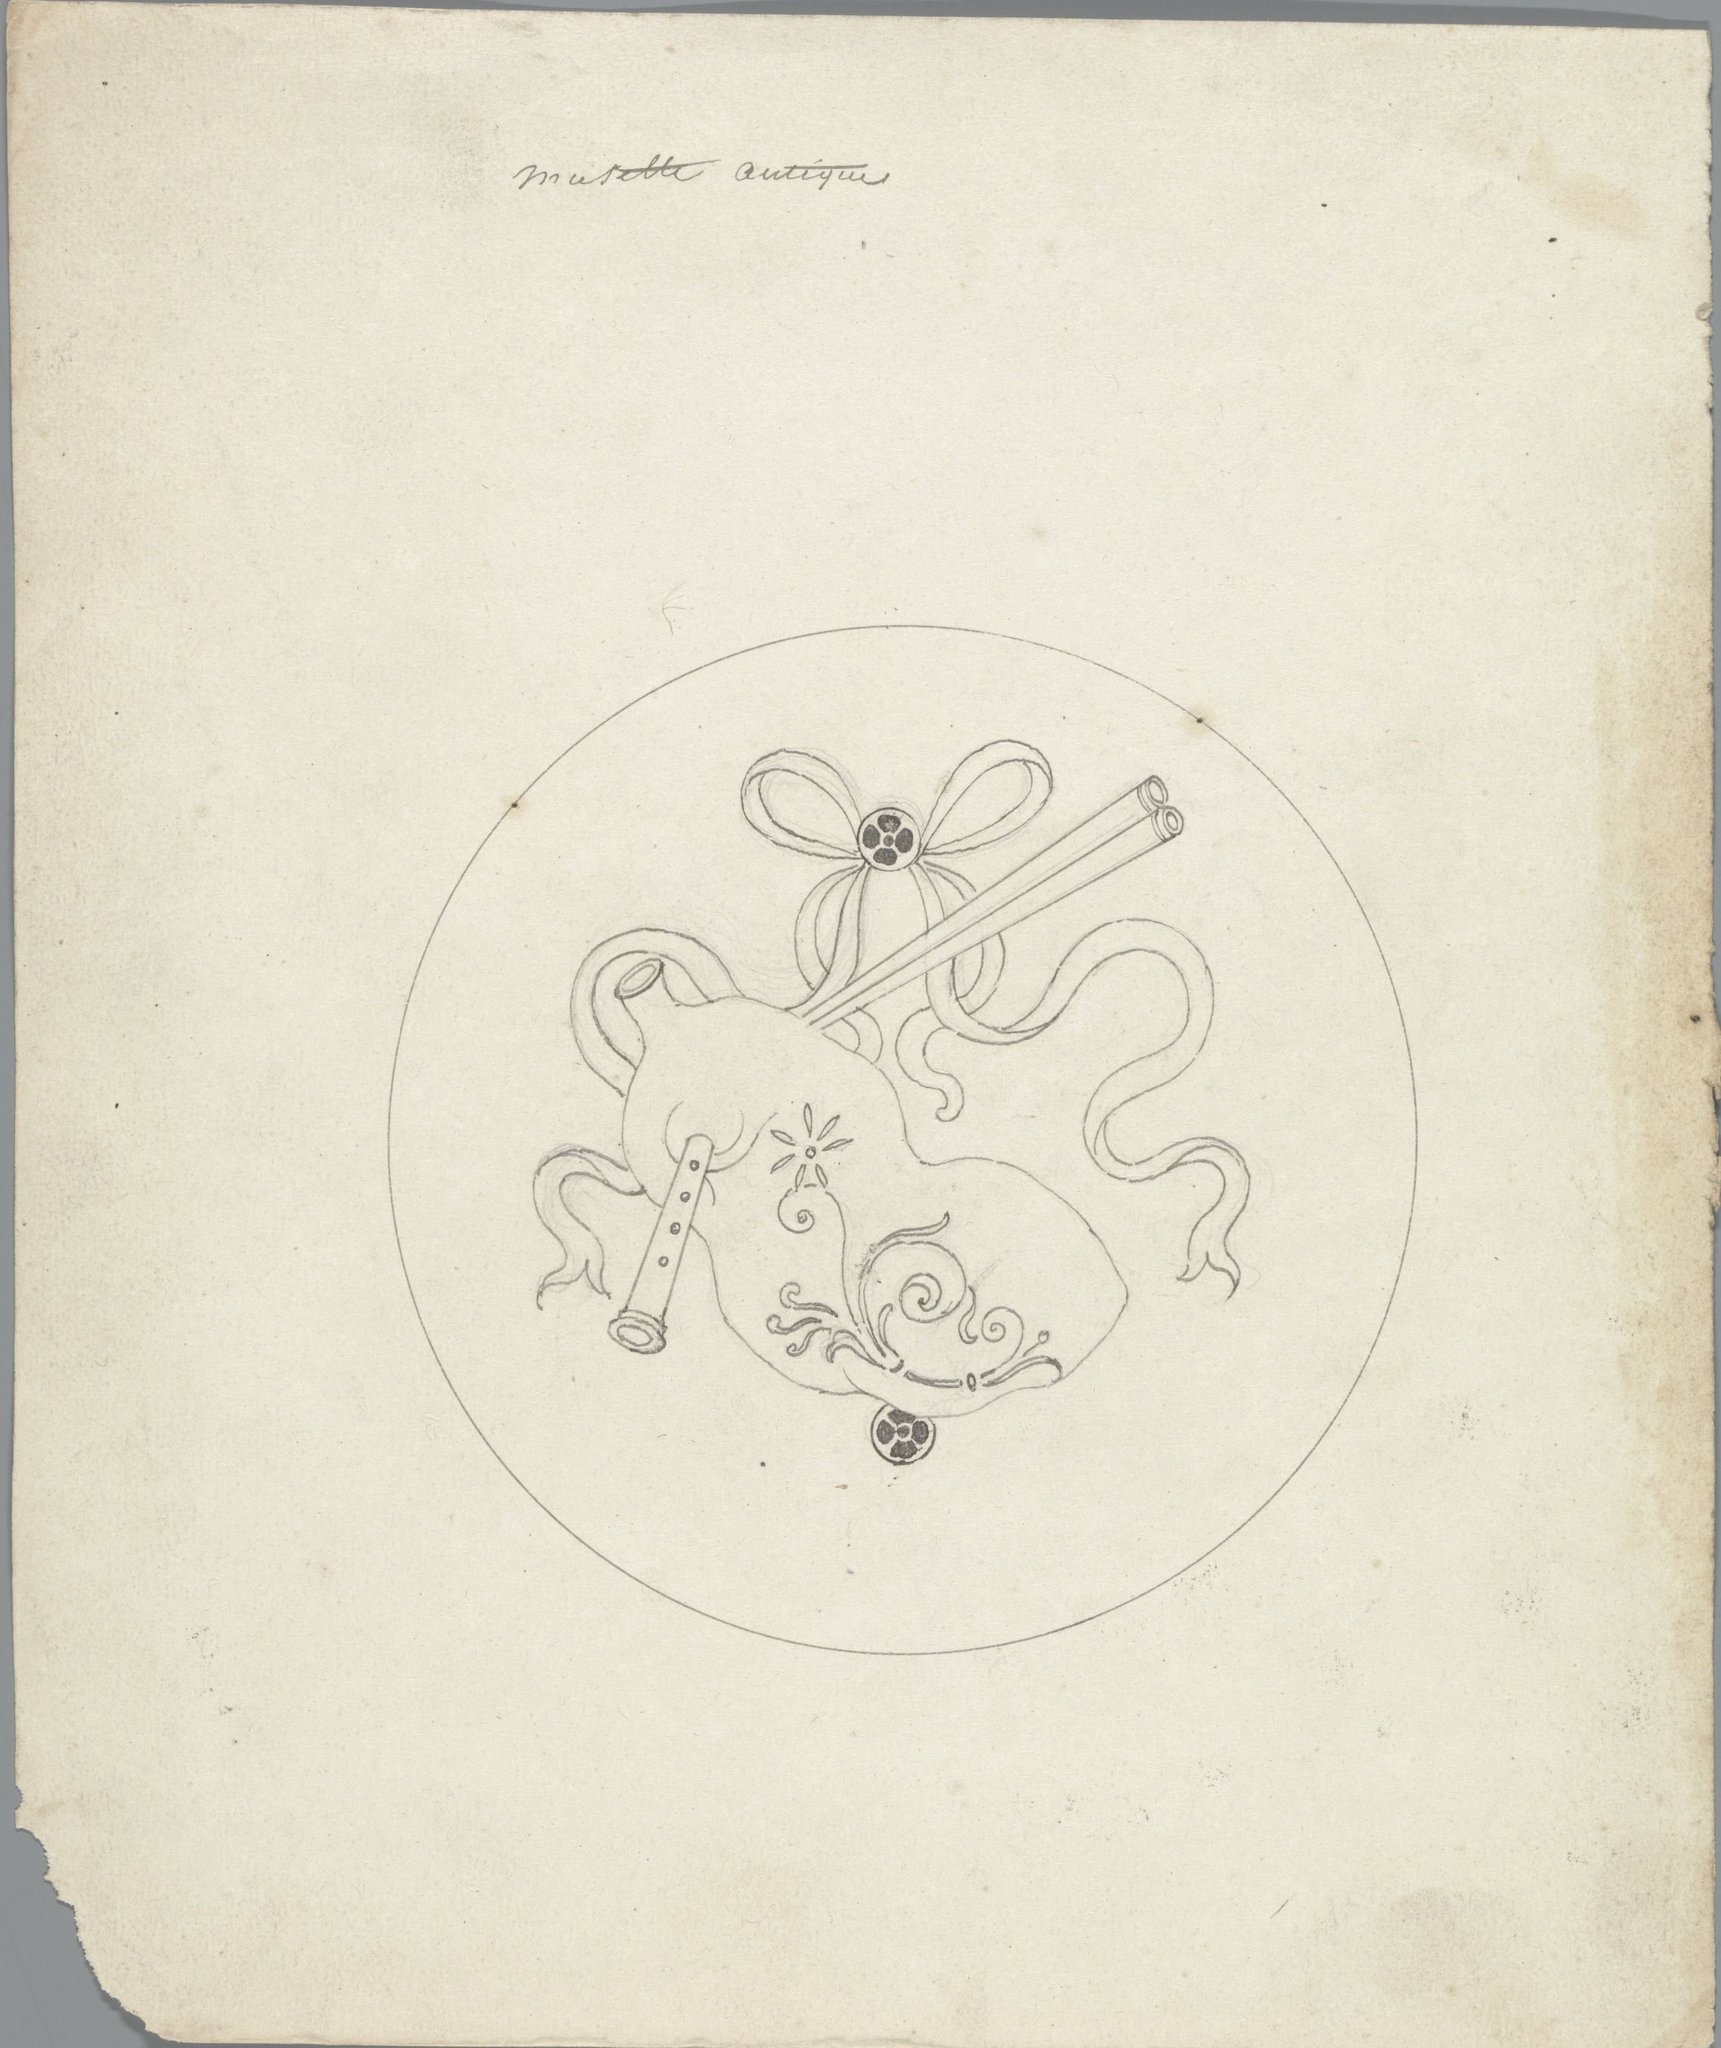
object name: design drawing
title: Ontwerp voor marqueterie van aan linten opgehangen muziekinstrument(en) in rond medaillon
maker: pierre félix van doren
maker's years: 1797-1856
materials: graphite, ink, paper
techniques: pen in black ink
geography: brussels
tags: trophy, i.e.: decorative arrangement of symbolic or typical objects ~ ornament, bagpipe, musette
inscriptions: inscription: ‘musette antique’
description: Een van 103 ontwerpen voor marqueterie van aan linten opgehangen muziekinstrumenten in ronde medaillons, bestemd voor de set stoelen gemaakt door Van Doren voor de grote zaal van het Paleis van de Prins van Oranje in Brussel in 1828.